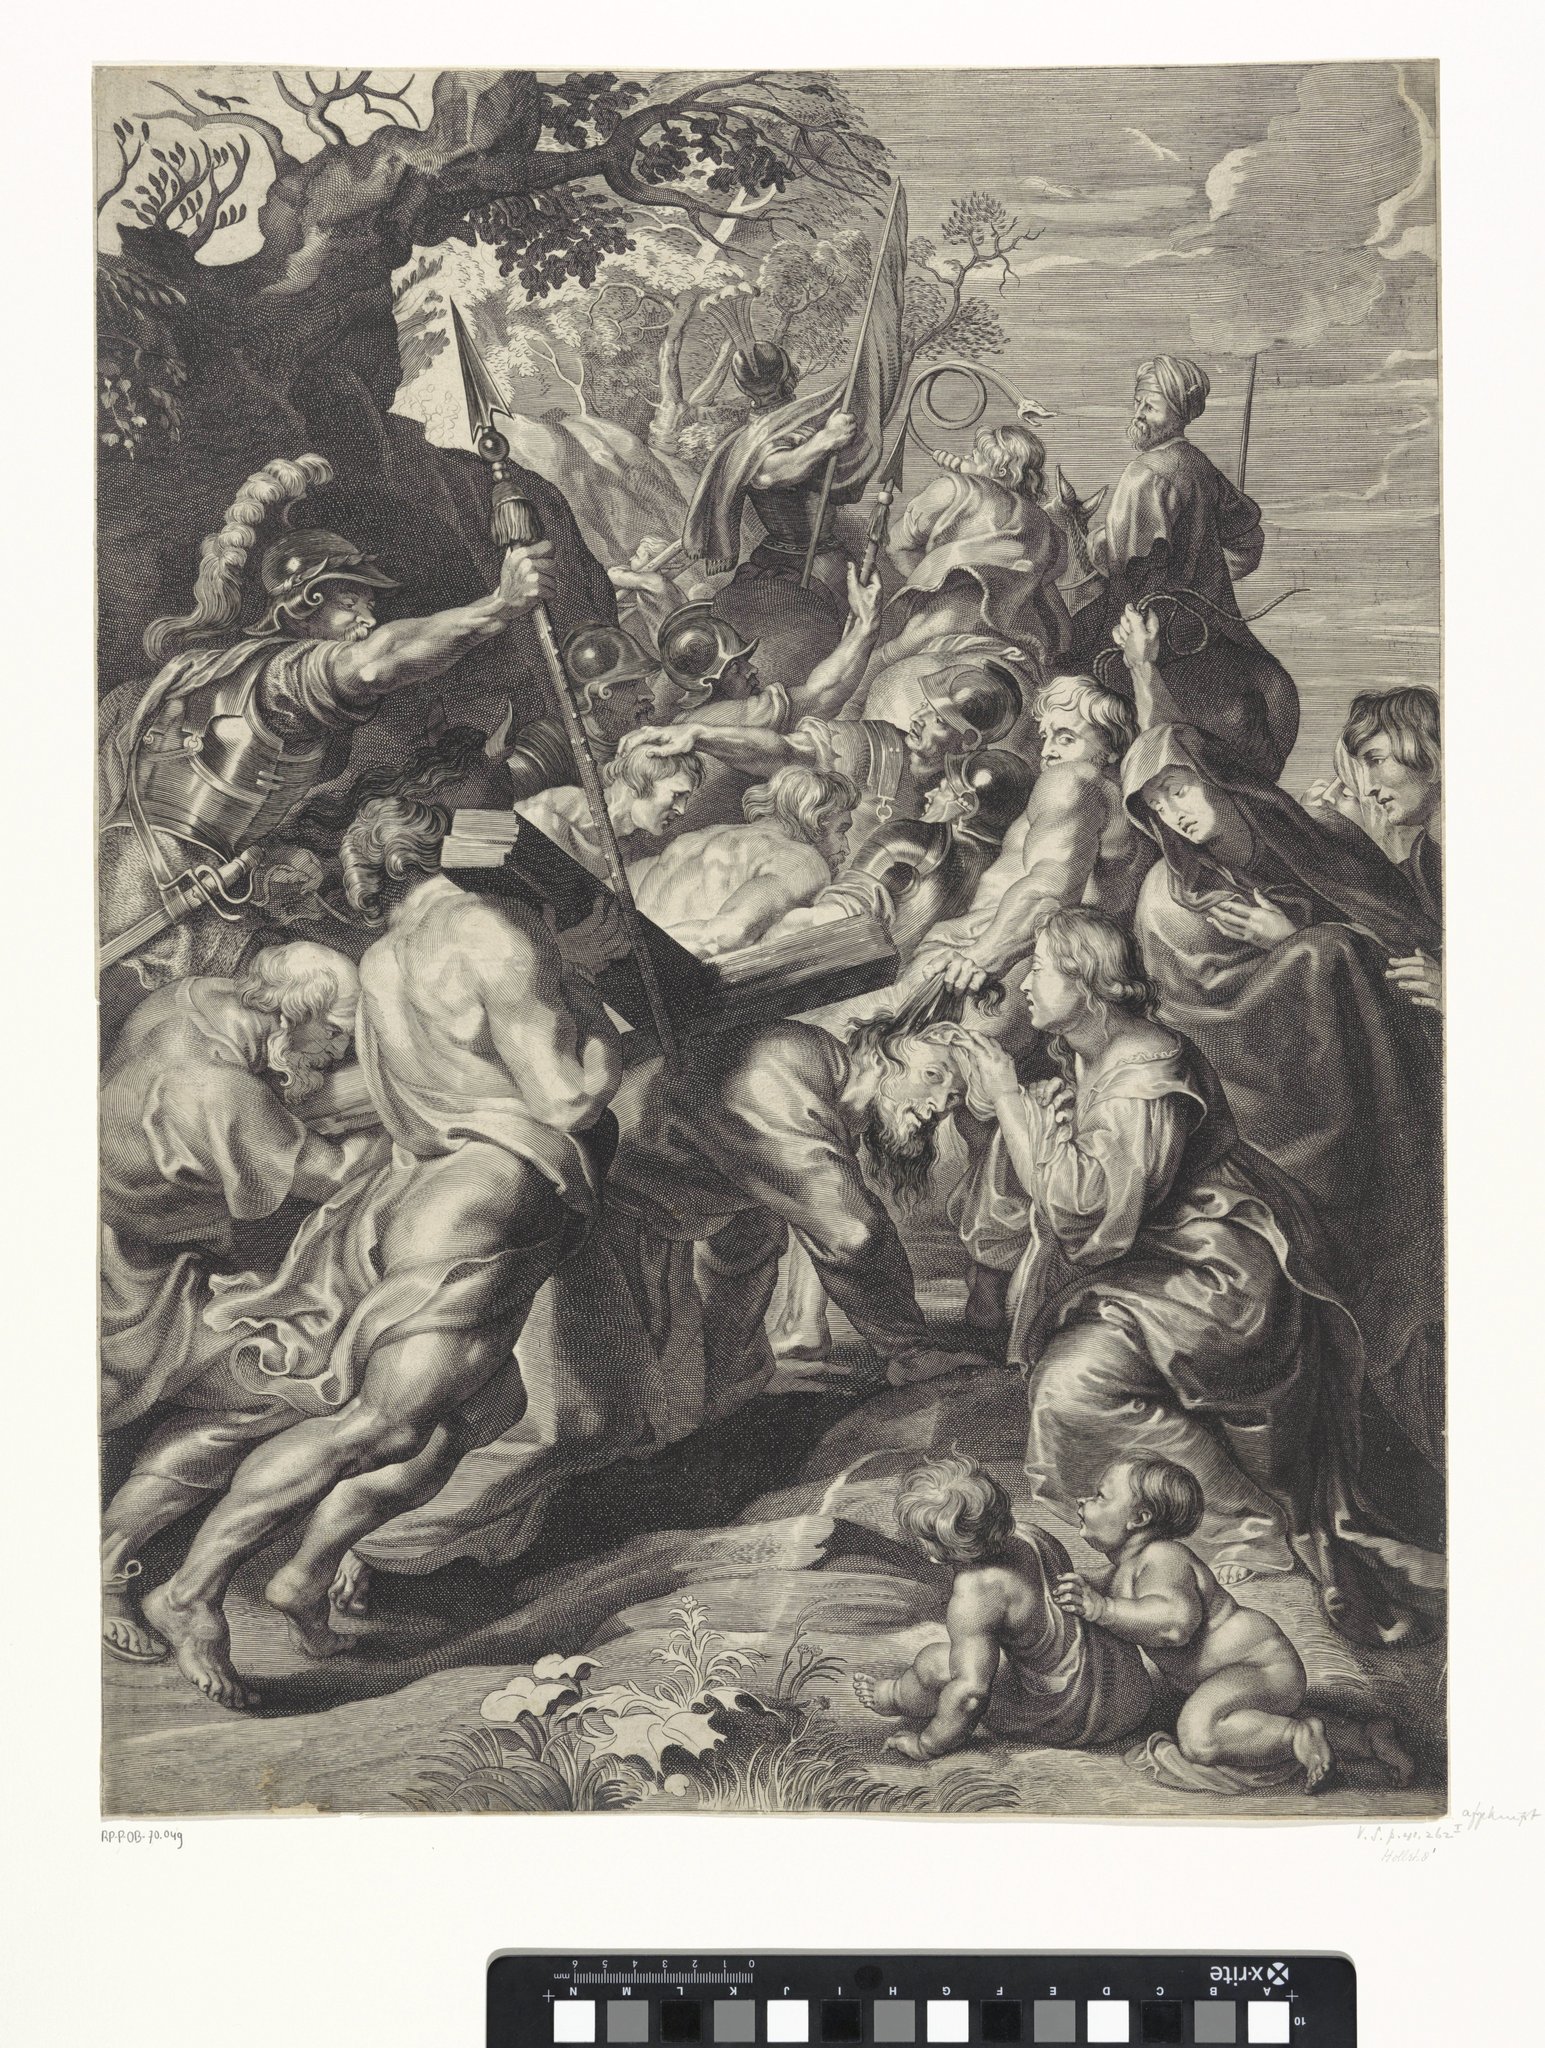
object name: print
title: Kruisdraging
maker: paulus pontius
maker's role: draughtsman, print maker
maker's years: 1603-1658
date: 1632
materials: paper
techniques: engraving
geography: antwerp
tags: christ collapsing ~ carrying of the cross, christ meets veronica, who has a cloth to wipe christ's face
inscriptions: collector's mark: Lugt 240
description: Christus valt tijdens het dragen van zijn kruis naar Golgota. Een Romeinse soldaat spoort hem aan om op te staan. De twee misdadigers lopen voor hem. Veronica wist het zweet van zijn gezicht met een doek. Omstanders kijken bedroefd toe.